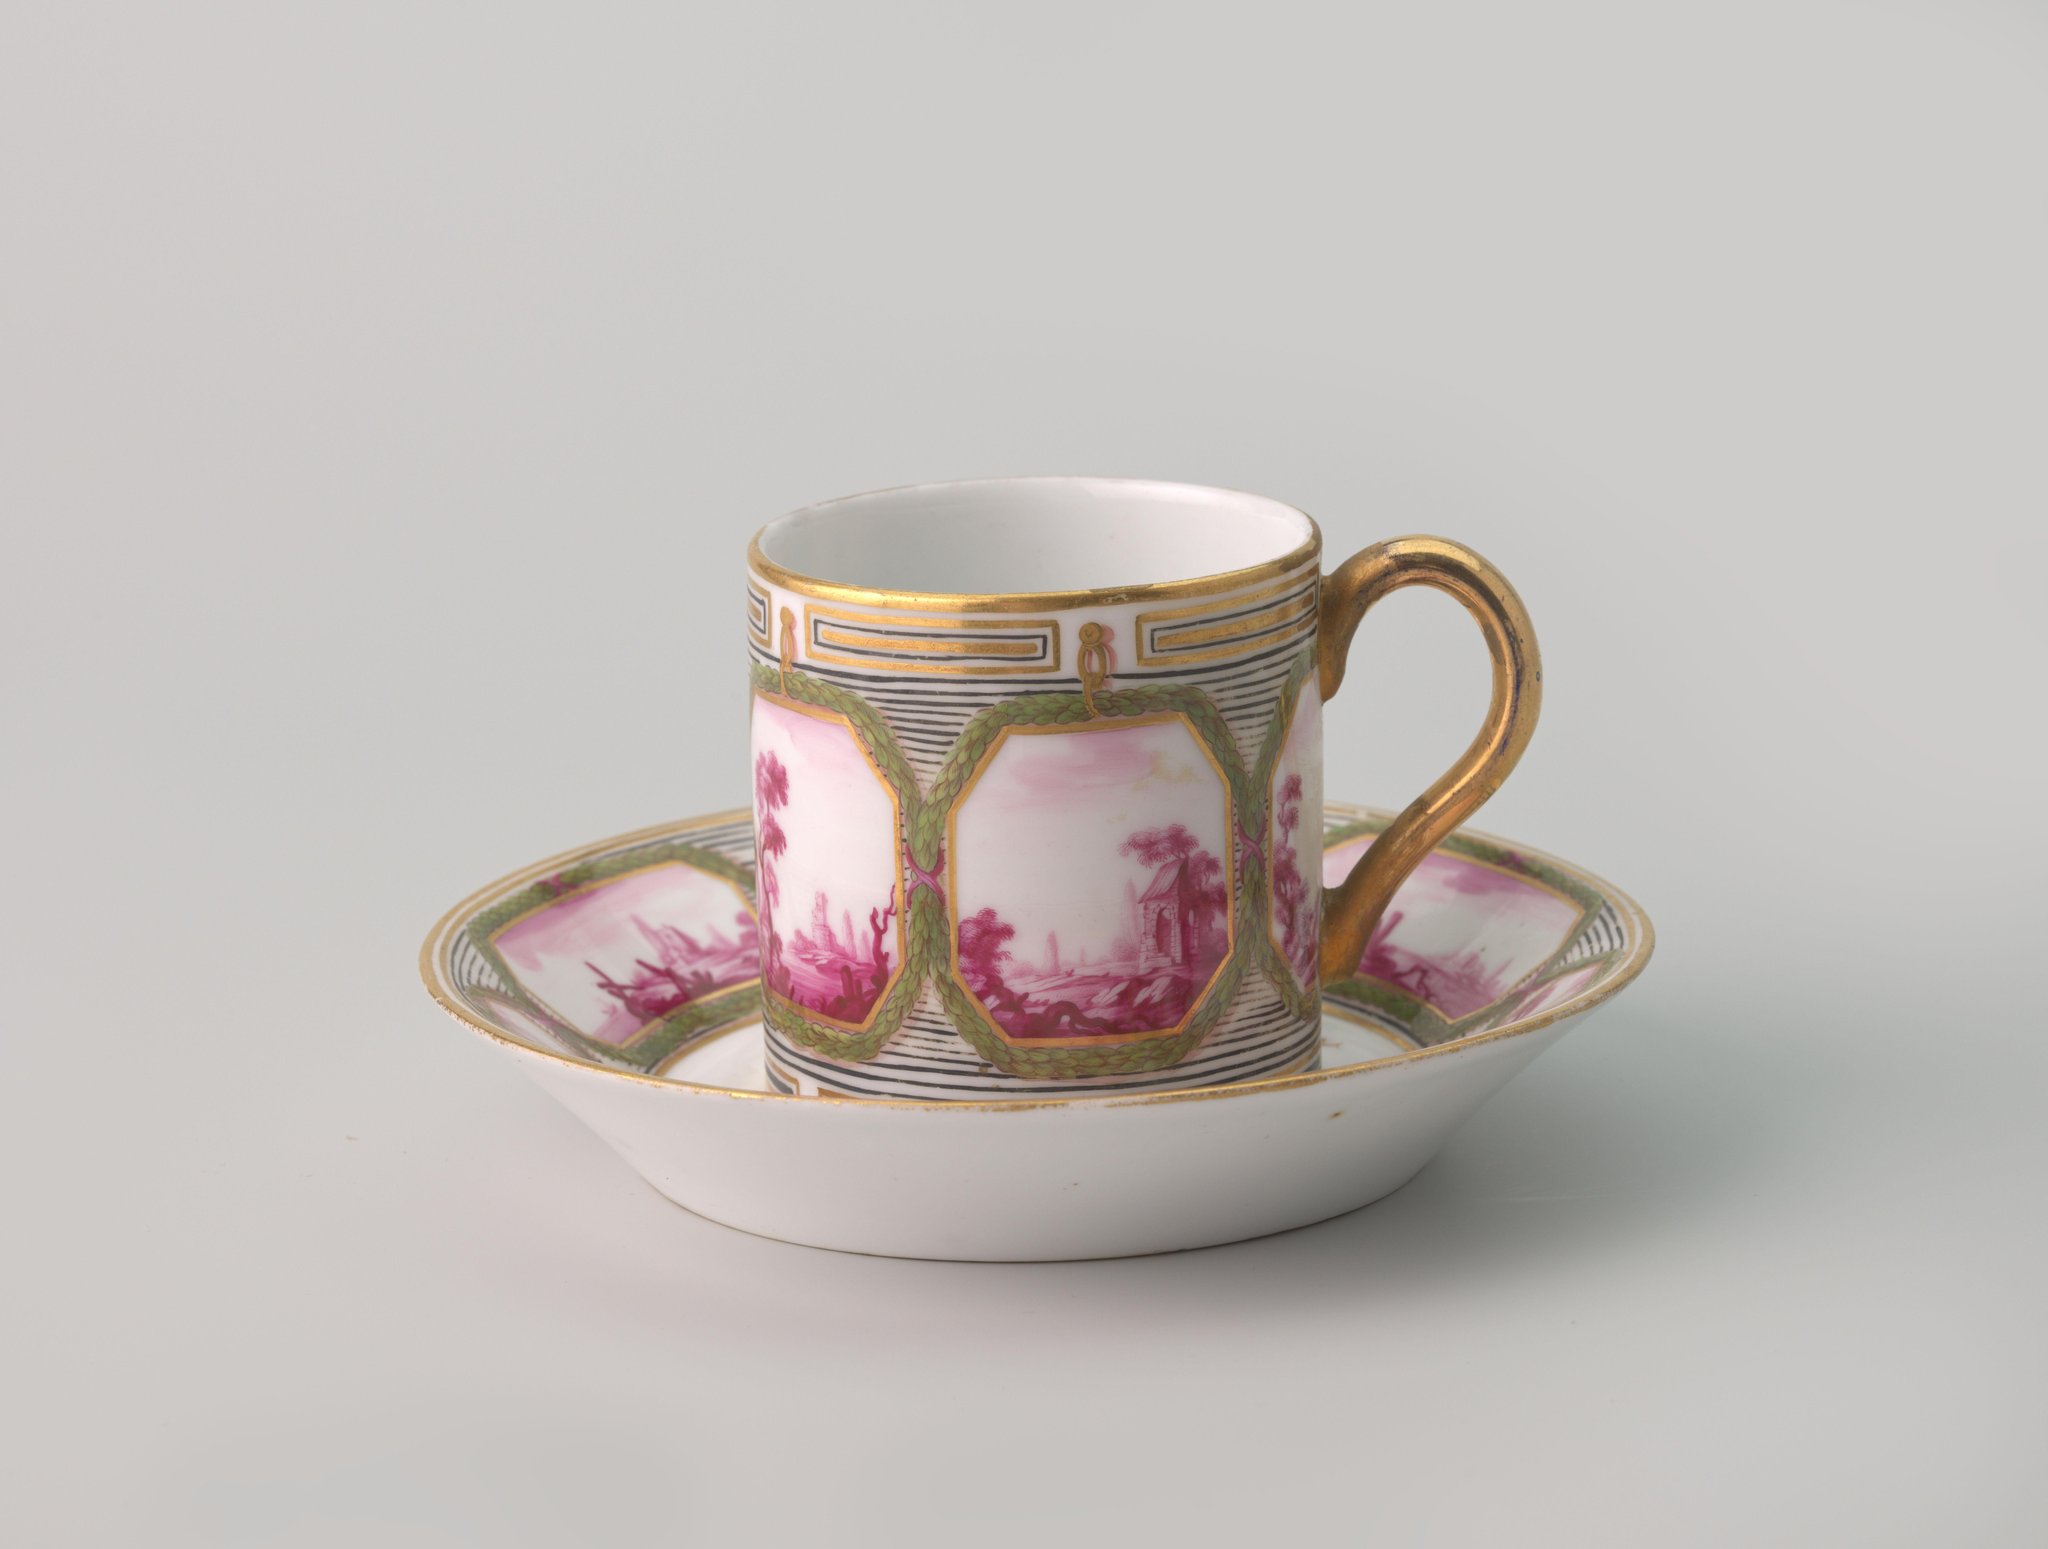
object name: cup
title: Cup with landscapes in panels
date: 1800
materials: glaze, gold, paint, porcelain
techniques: firing, gilding, turning, vitrification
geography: niderviller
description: Kop van porselein met een cilindrische wand en C-vormig oor, beschilderd op het glazuur in rood, roze, groen, zwart en goud. De buitenwand is bedekt met horizontale zwarte strepen met aan de boven- en onderzijde rechthoekige, gouden vakken. Hierin uitgespaard een band van aaneengebonden vakken van bladerkransen met daarin landschappen in camaïeu. Gouden rand en oor.